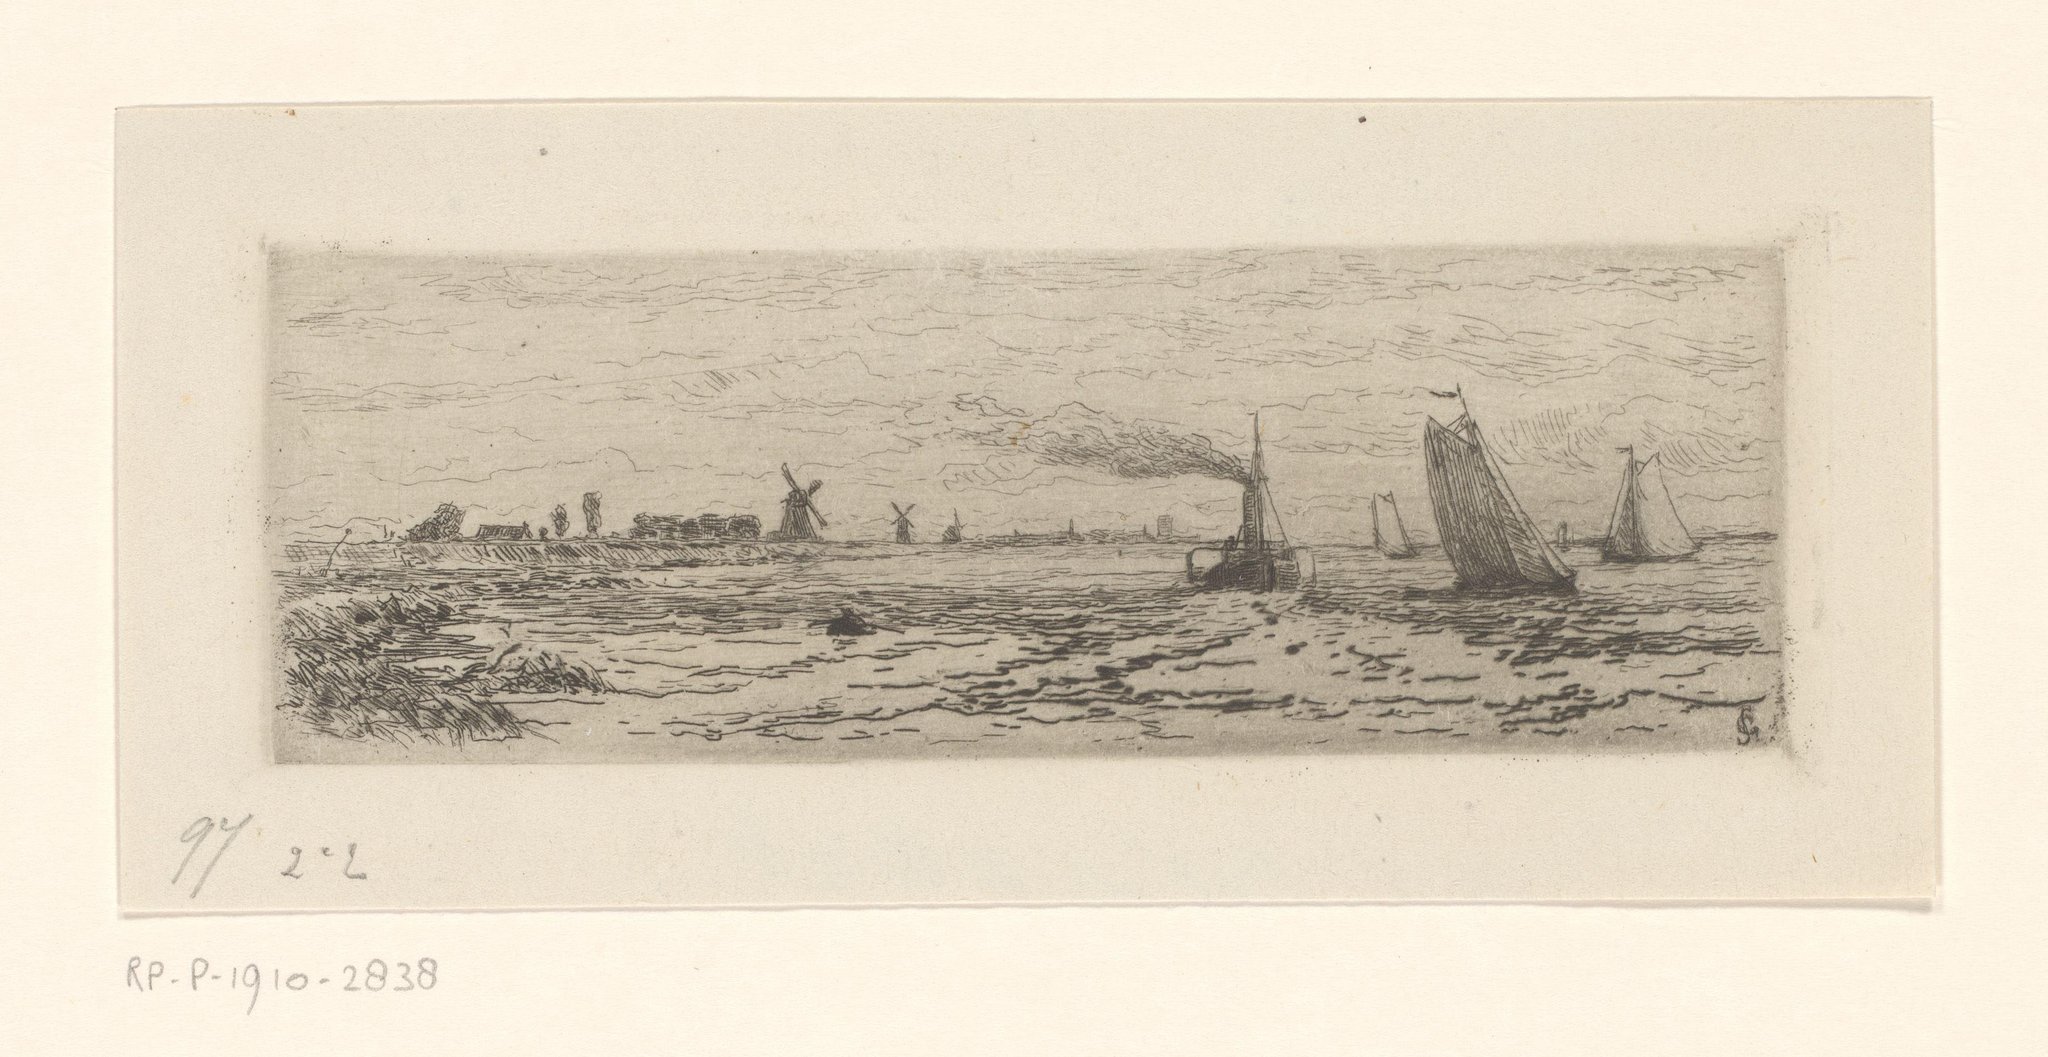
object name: print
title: Gezicht op de Maas tussen Dordrecht en Rotterdam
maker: carel nicolaas storm van s-gravesande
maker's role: draughtsman, print maker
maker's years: 1841-1924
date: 1877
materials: paper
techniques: drypoint, etching, intaglio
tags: river, ships (in general), windmill in landscape, dordrecht, rotterdam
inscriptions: collector's mark: Lugt 2228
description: Links op de oever een rij molens. Rechts op het water zeilschepen en een stoomboot.